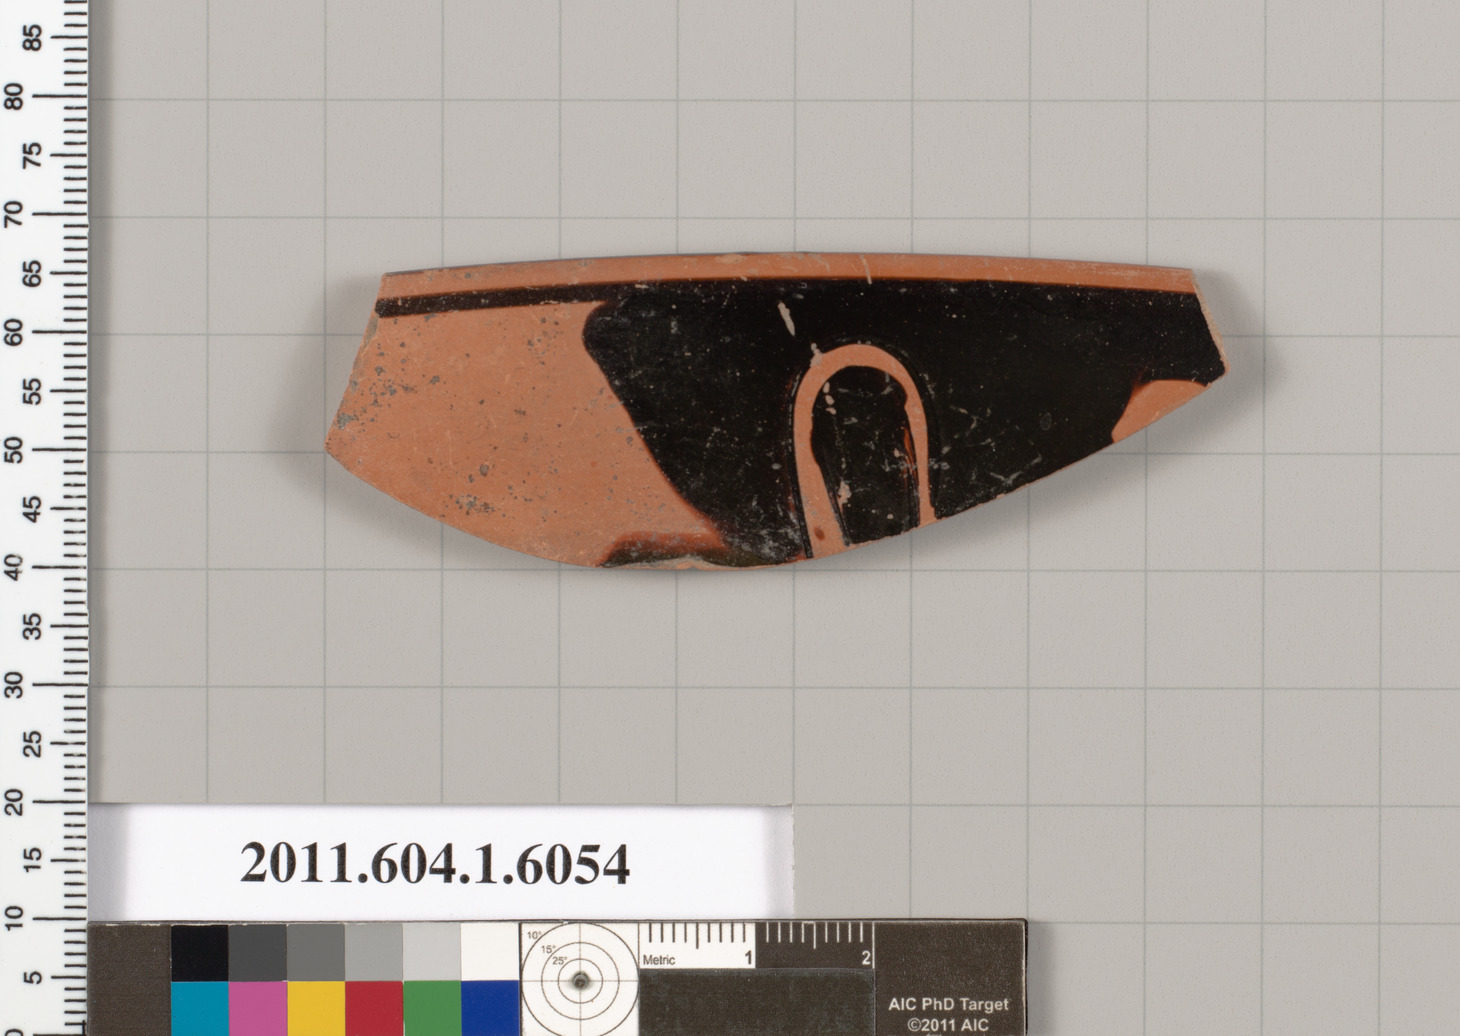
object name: kylix fragment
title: Terracotta rim fragment of a kylix (drinking cup)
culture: greek, attic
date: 510-500 BCE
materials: terracotta